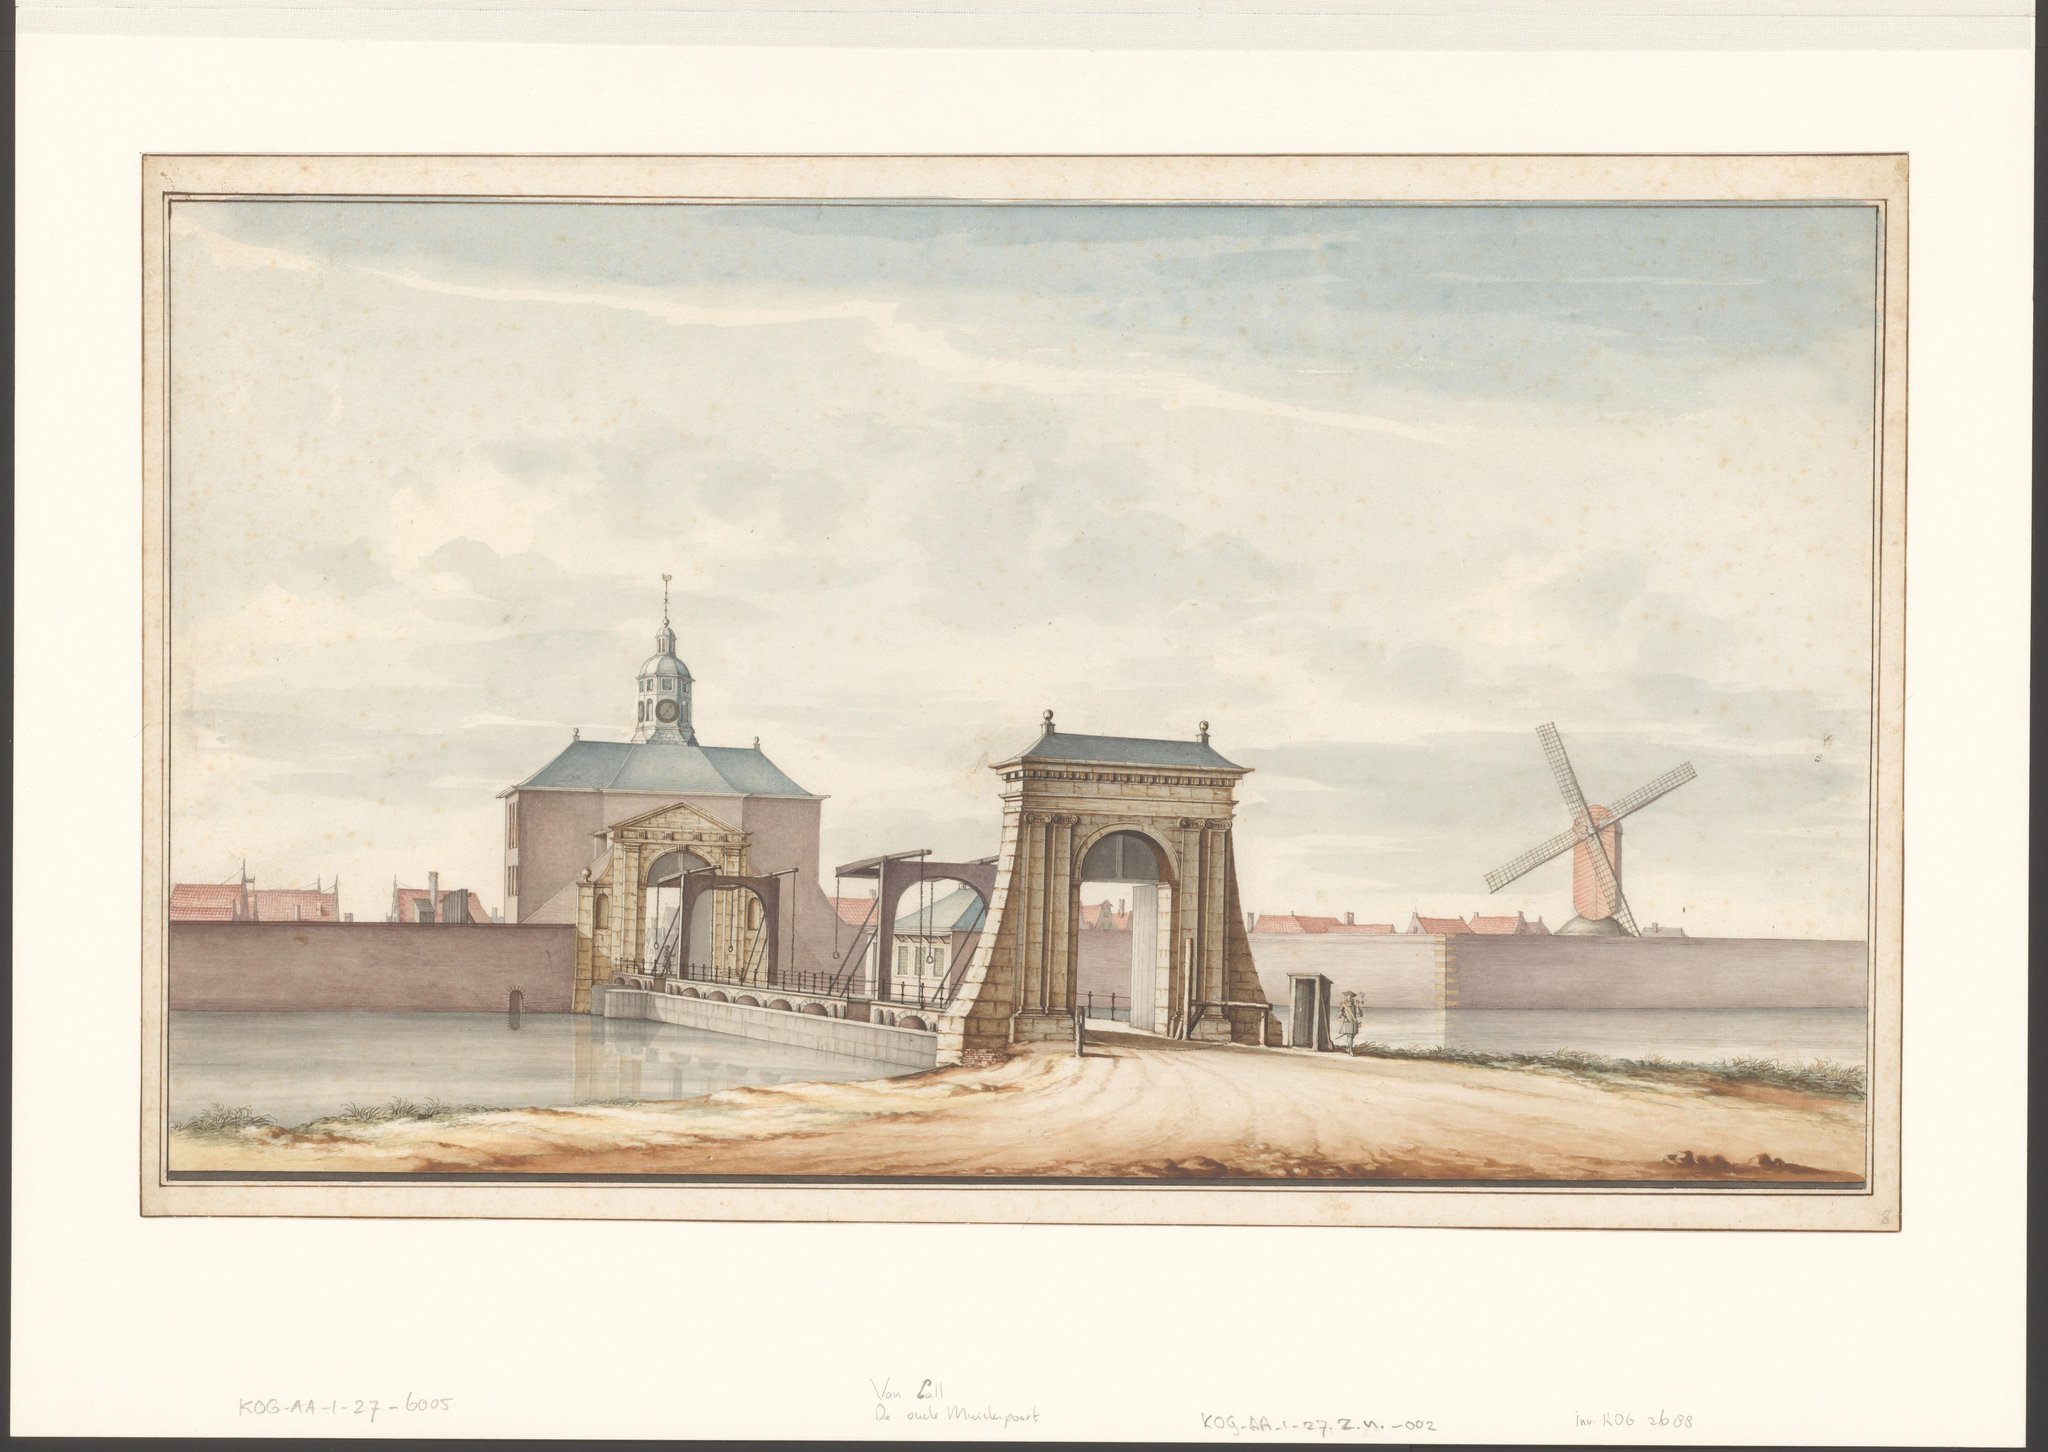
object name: drawing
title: Gezicht op de oude Muiderpoort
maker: jan van call (i)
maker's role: draughtsman, print maker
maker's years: 1656-1706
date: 1666-1703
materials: ink, paper, pencil, watercolor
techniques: brush, pen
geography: amsterdam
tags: city-view in general; 'veduta', city-gate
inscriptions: inscription: ‘Van Call / De Oude Muiderpoort’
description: Onderwerpsrubriek binnen de Atlas Amsterdam: Eerste Muiderpoort.